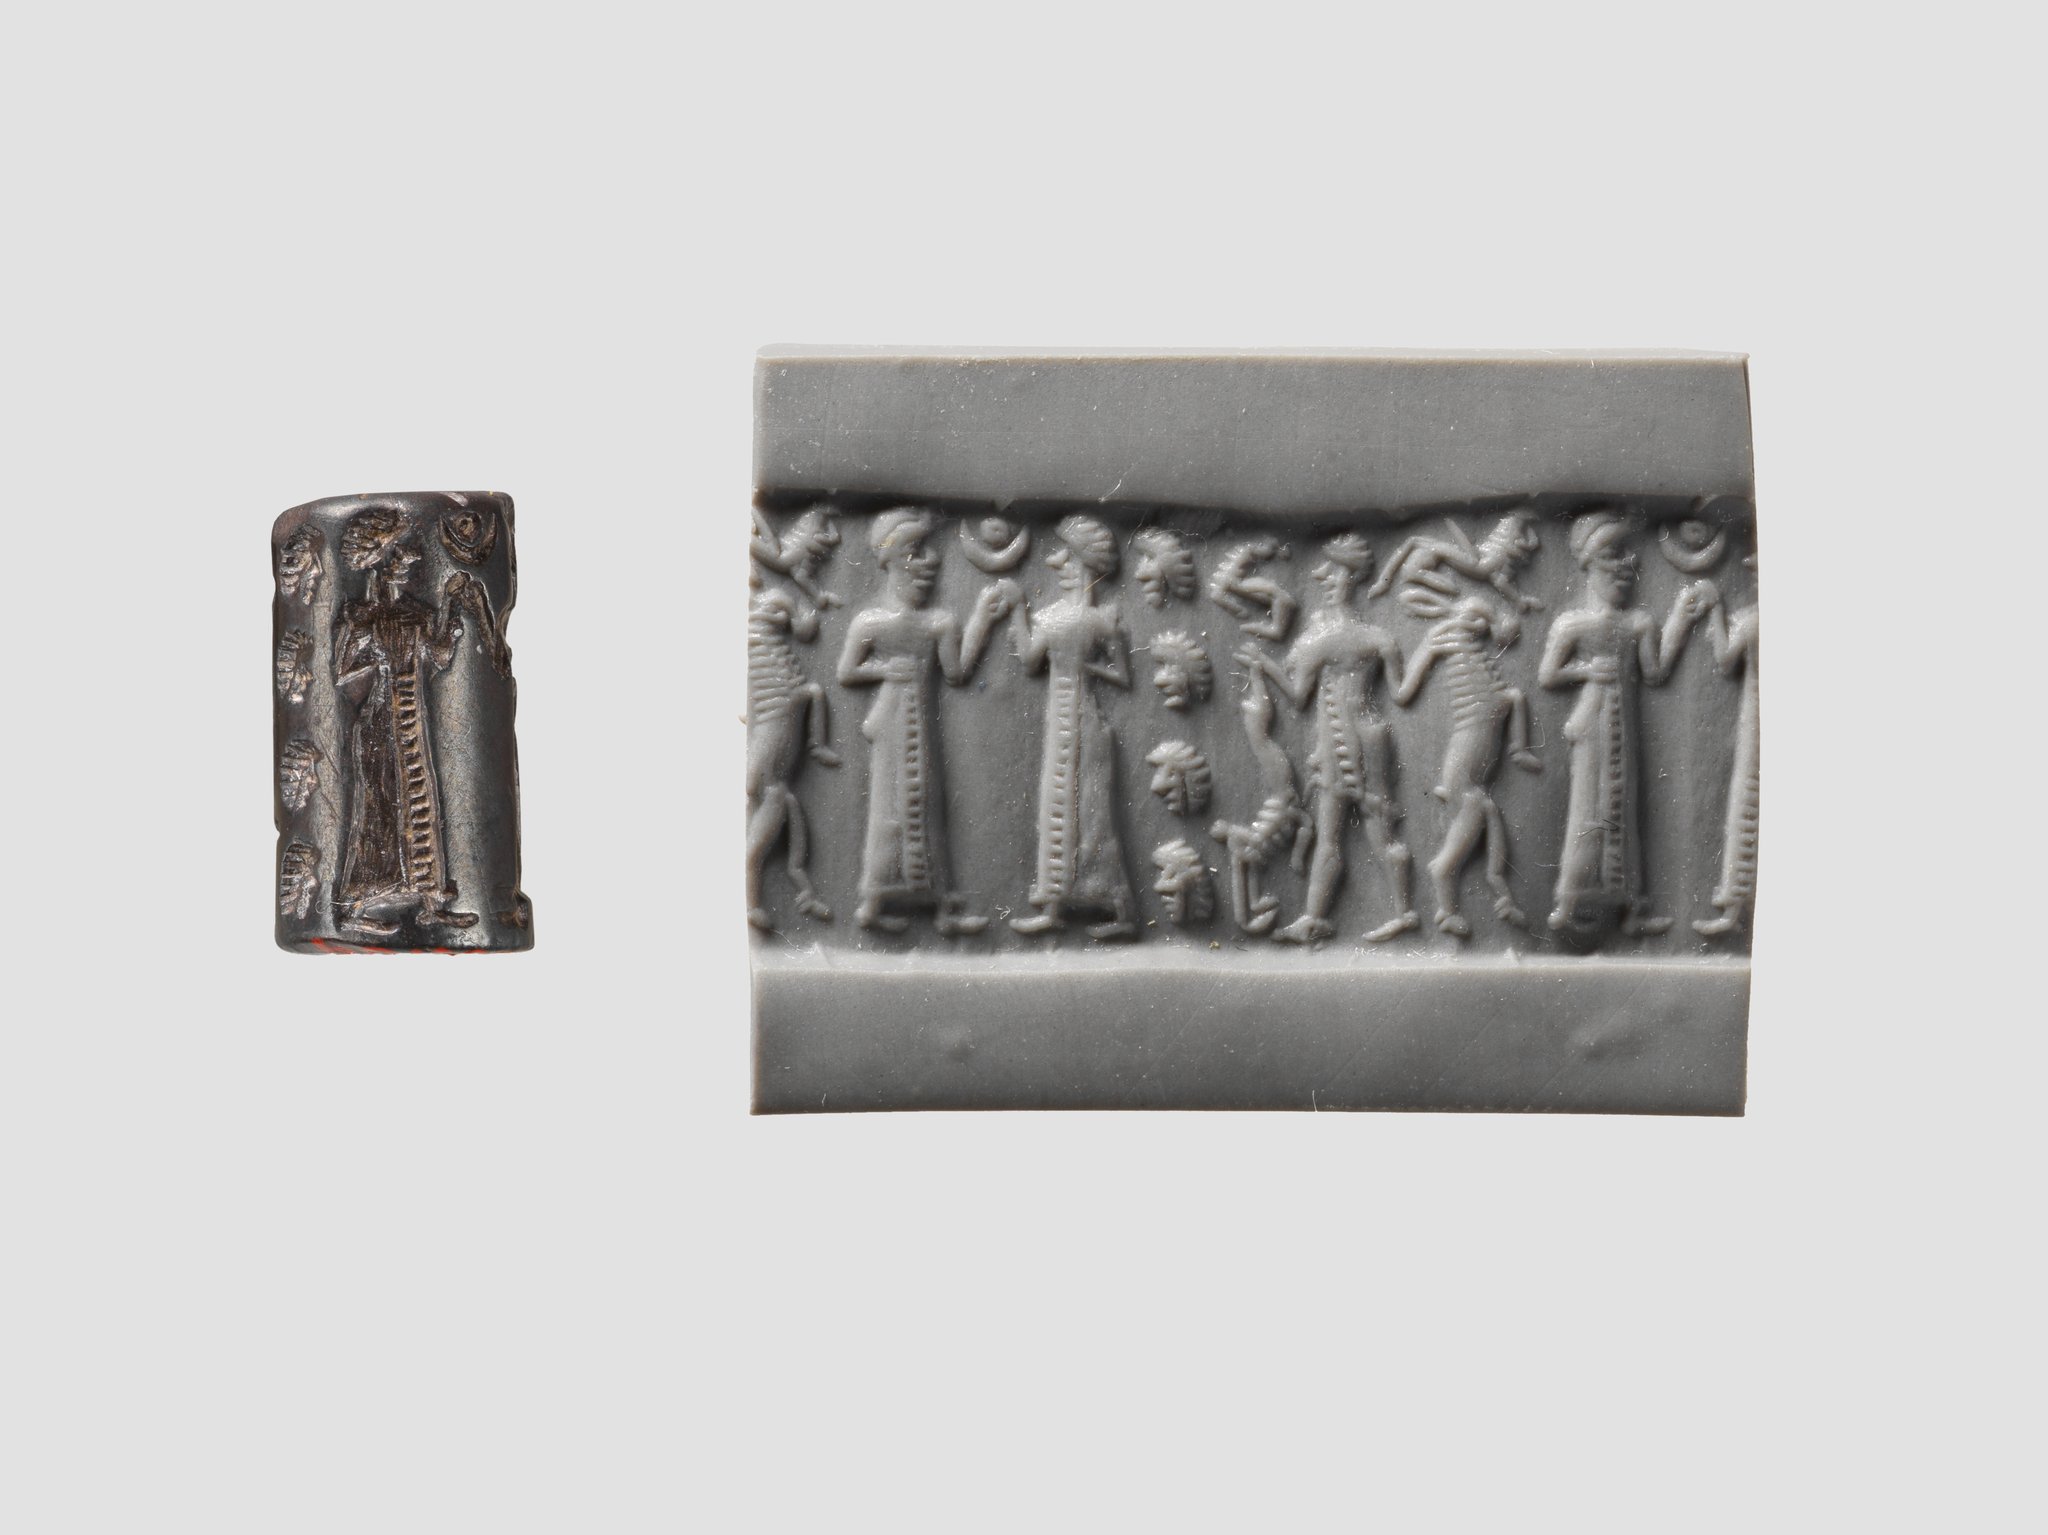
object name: cylinder seal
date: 2000-1668 BCE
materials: mineral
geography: syria